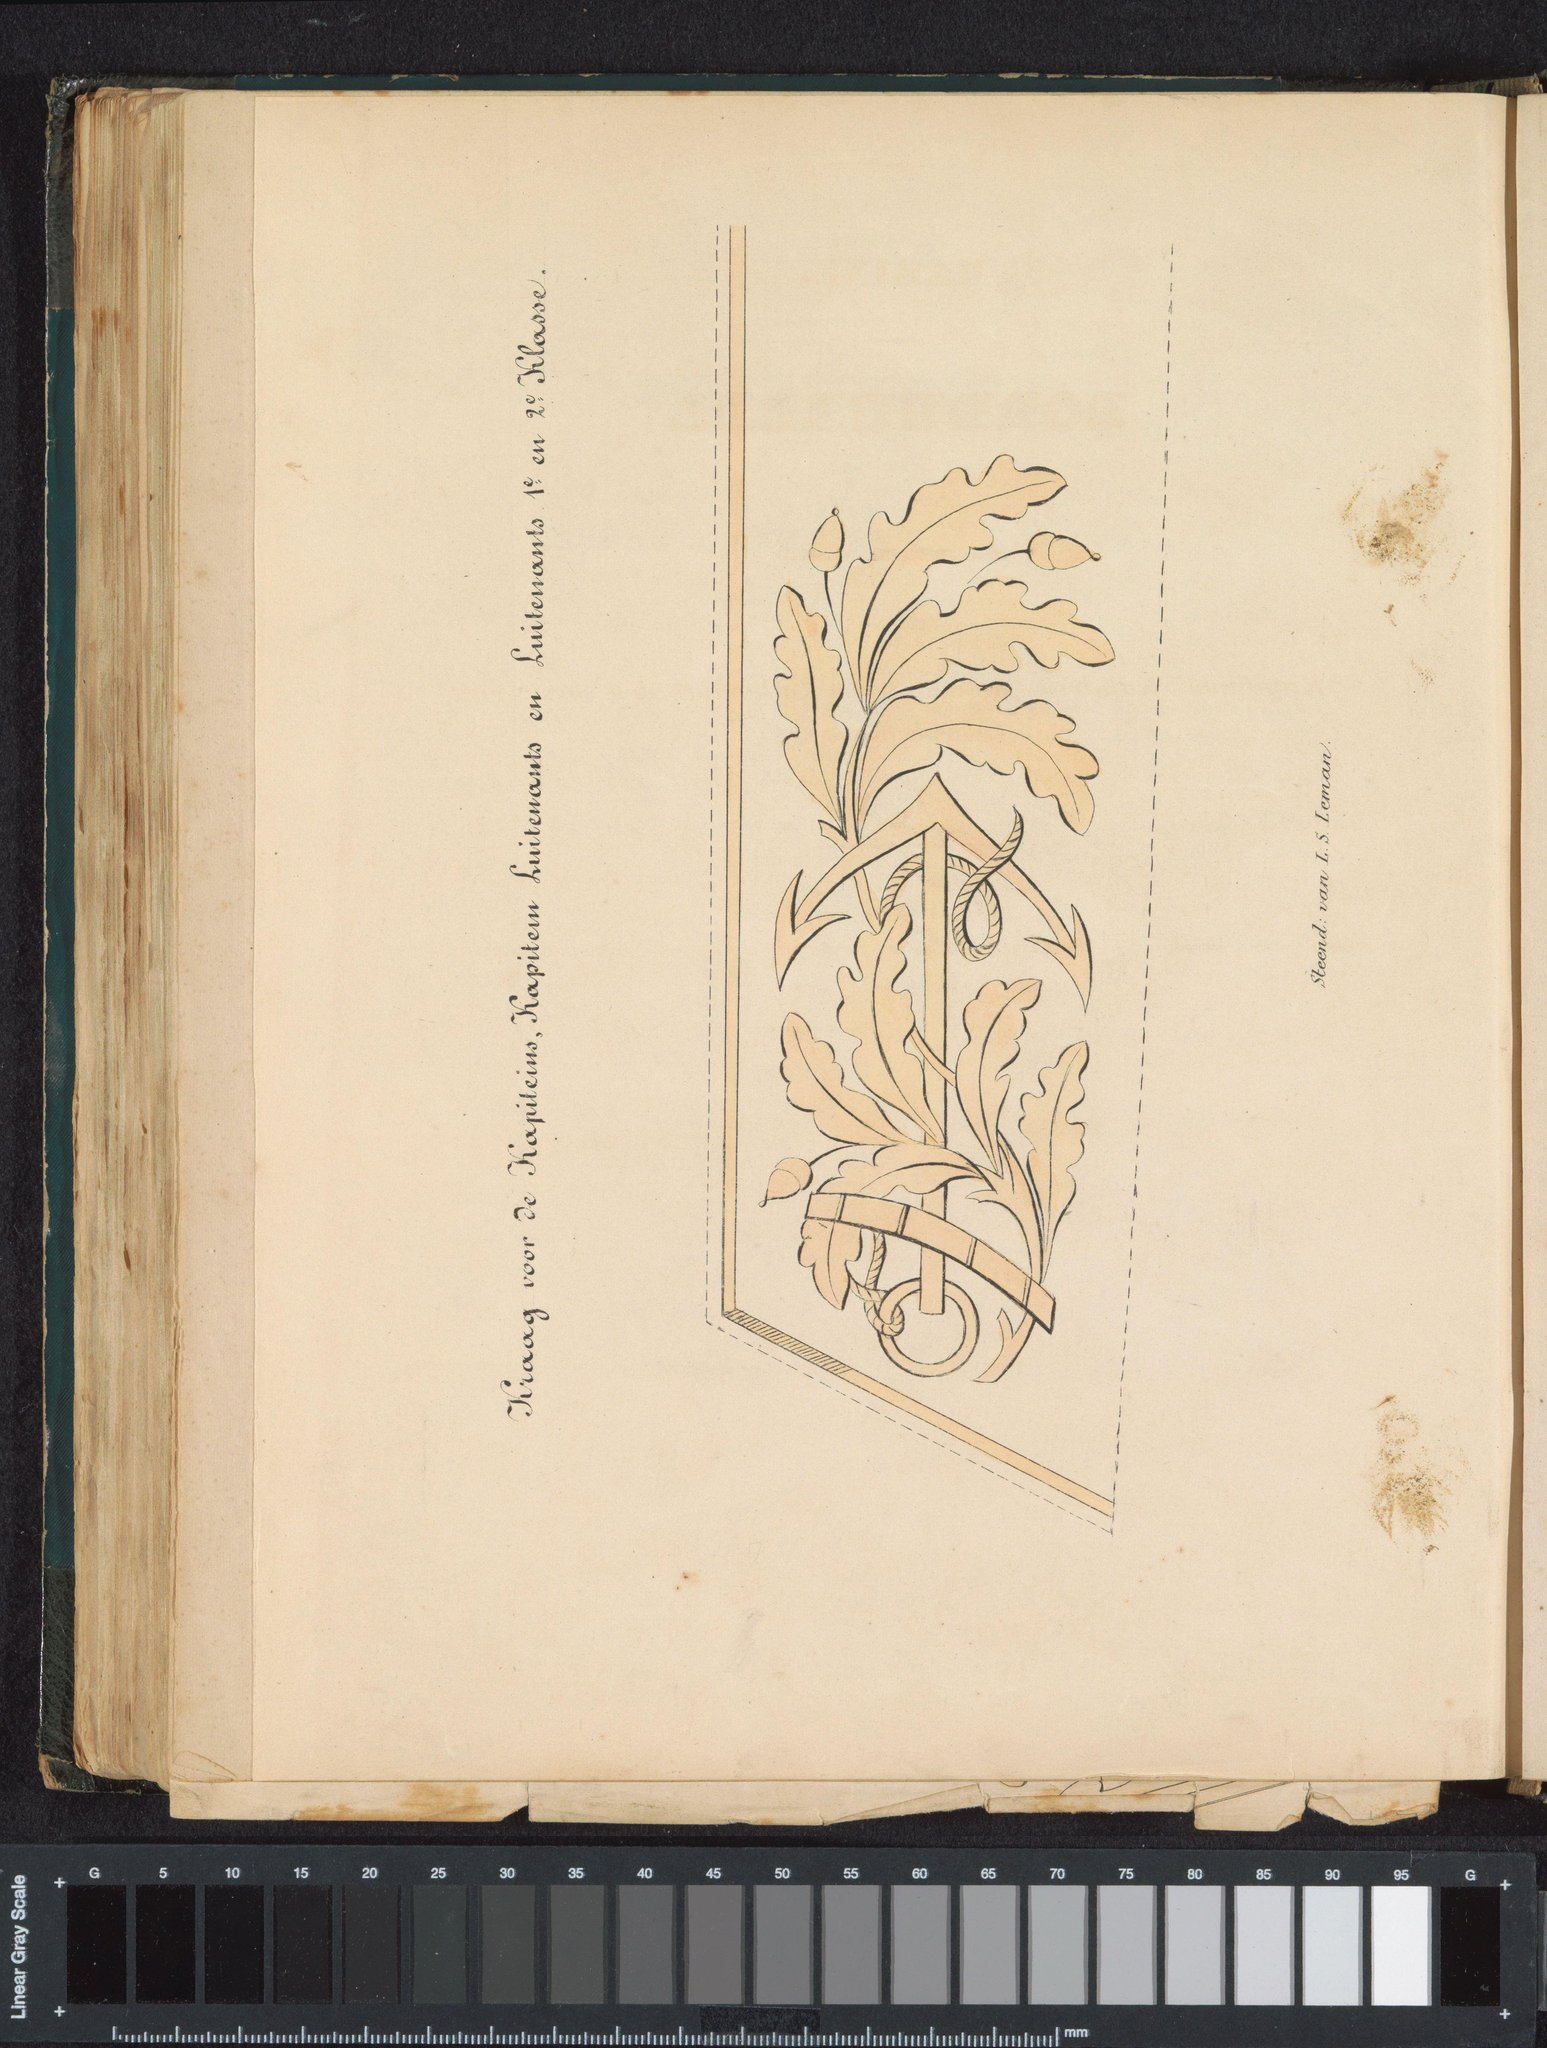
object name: costume print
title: Borduursel voor het uniform voor de kapiteins, kapiteins-luitenant en luitenants eerste en tweede klasse van de Marine, 1845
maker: louis salomon leman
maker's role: steendrukker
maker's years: 1818-1889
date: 1845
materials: paper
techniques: hand coloring, lithograph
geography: amsterdam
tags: (military) uniforms, netherlands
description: Borduursel voor het uniform voor de kapiteins, kapiteins-luitenant en luitenants eerste en tweede klasse van de Marine. Illustratie in een boek uit 1845 over de uniformen en kledingstukken van de Nederlandse land-, zeemacht en schutterijen in Nederland en in de overzeese gebiedsdelen.